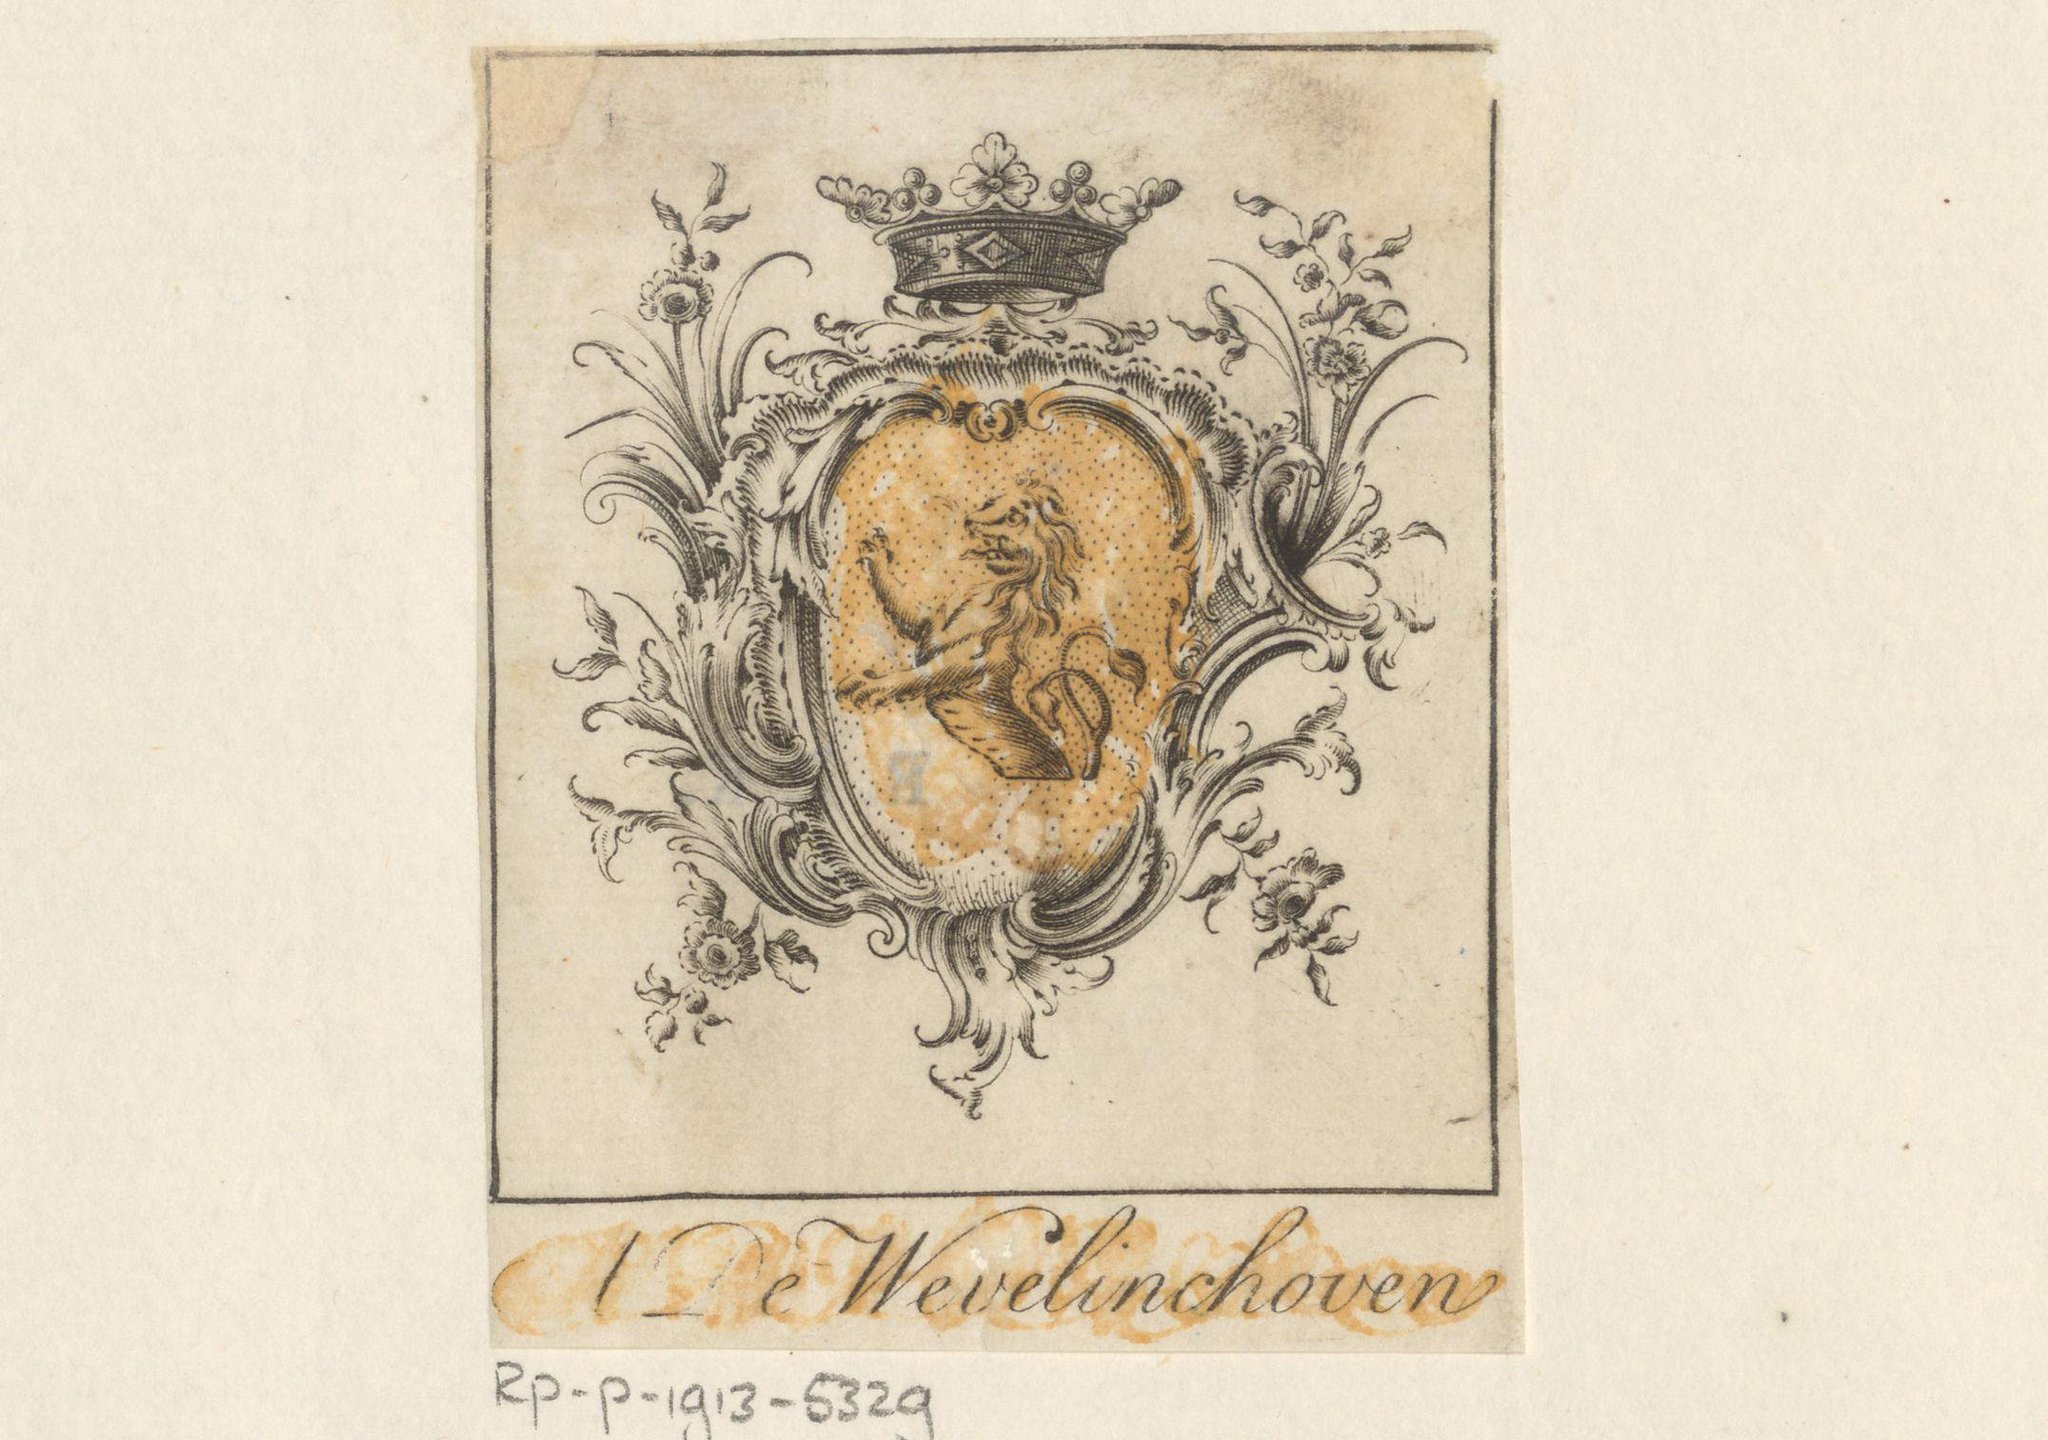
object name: bookplate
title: Ex libris van De Wevelinchoven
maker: Anonymous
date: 1750-1799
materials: ink, paper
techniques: engraving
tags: armorial bearing, heraldry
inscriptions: collector's mark: Lugt 2760, collector's mark: Lugt 2233